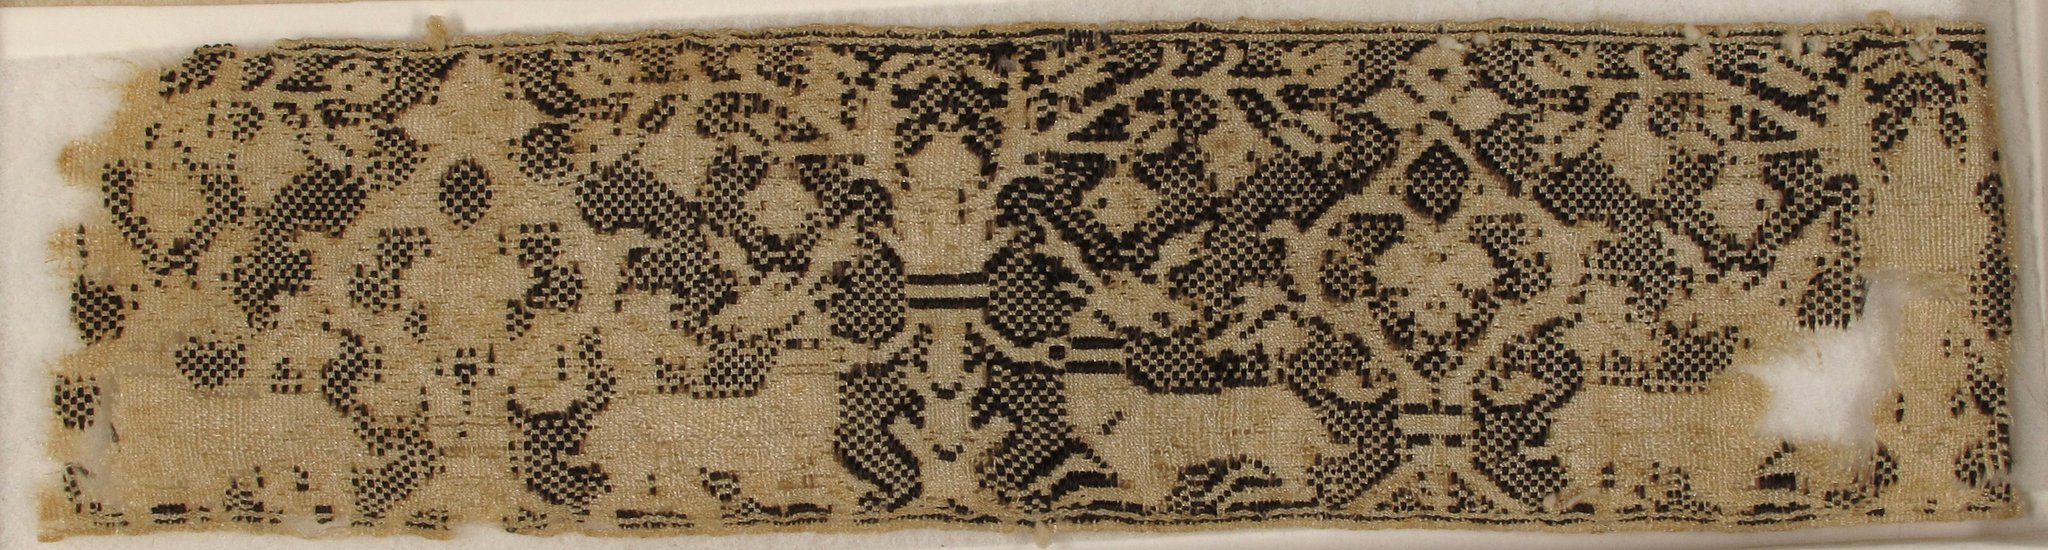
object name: textile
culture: italian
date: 1467-1500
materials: silk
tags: animals,flowers